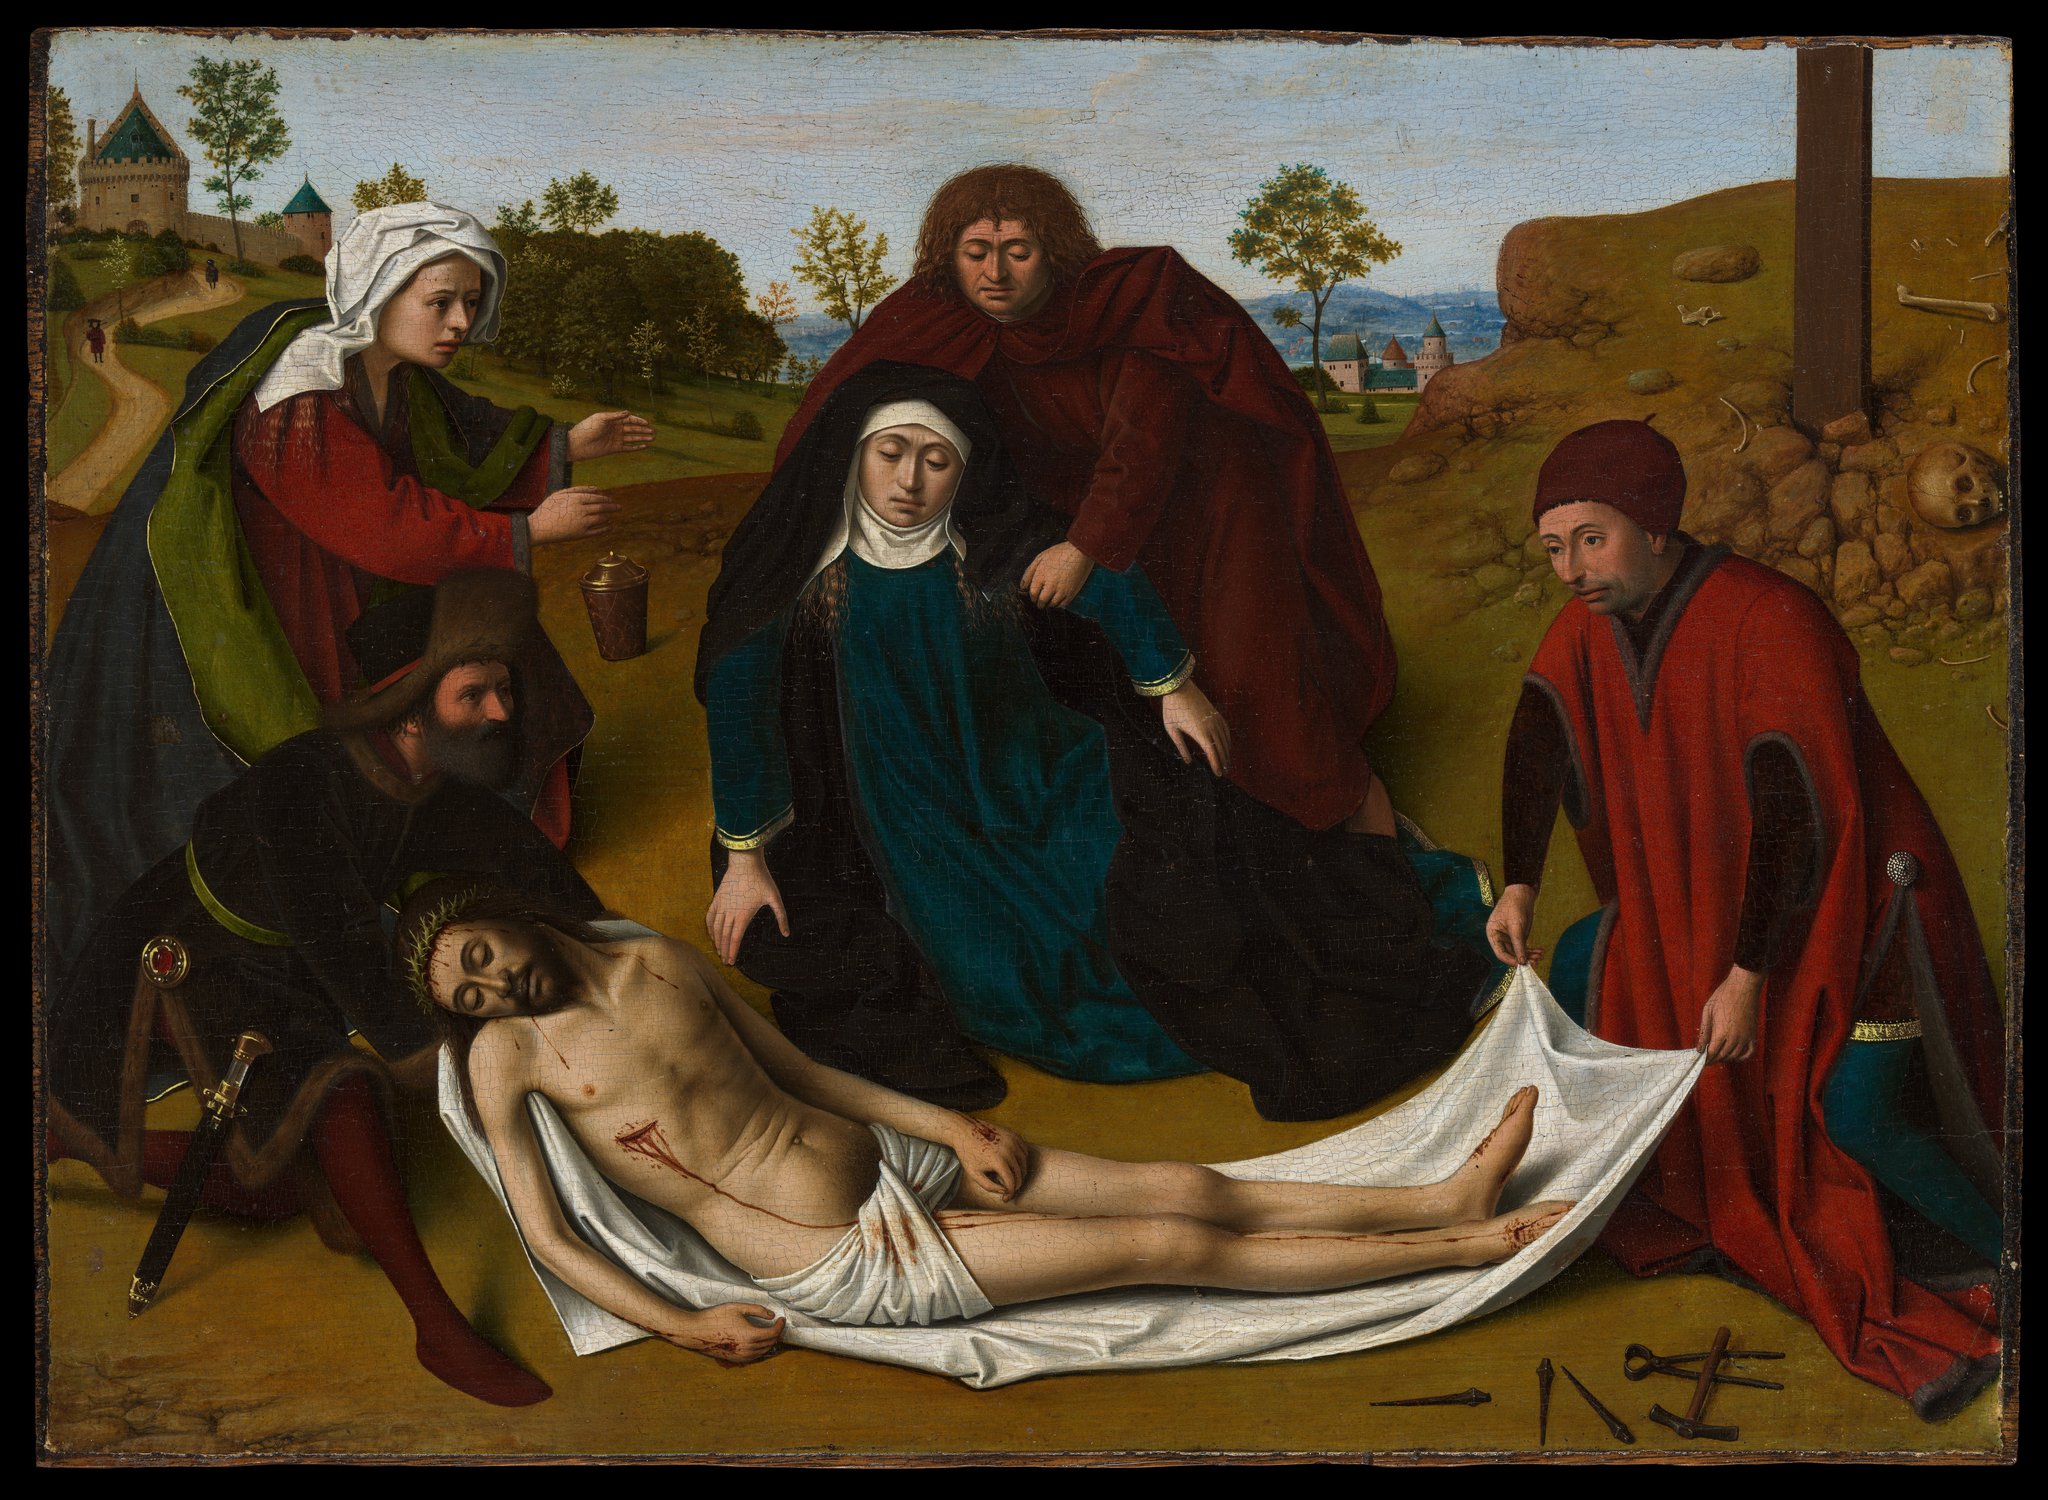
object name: painting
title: The Lamentation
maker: petrus christus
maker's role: artist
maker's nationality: netherlandish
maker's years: 1444-1476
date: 1450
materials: oil, wood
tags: sadness,suffering,christ,mary magdalene,saint john the evangelist,virgin mary,lamentation,death